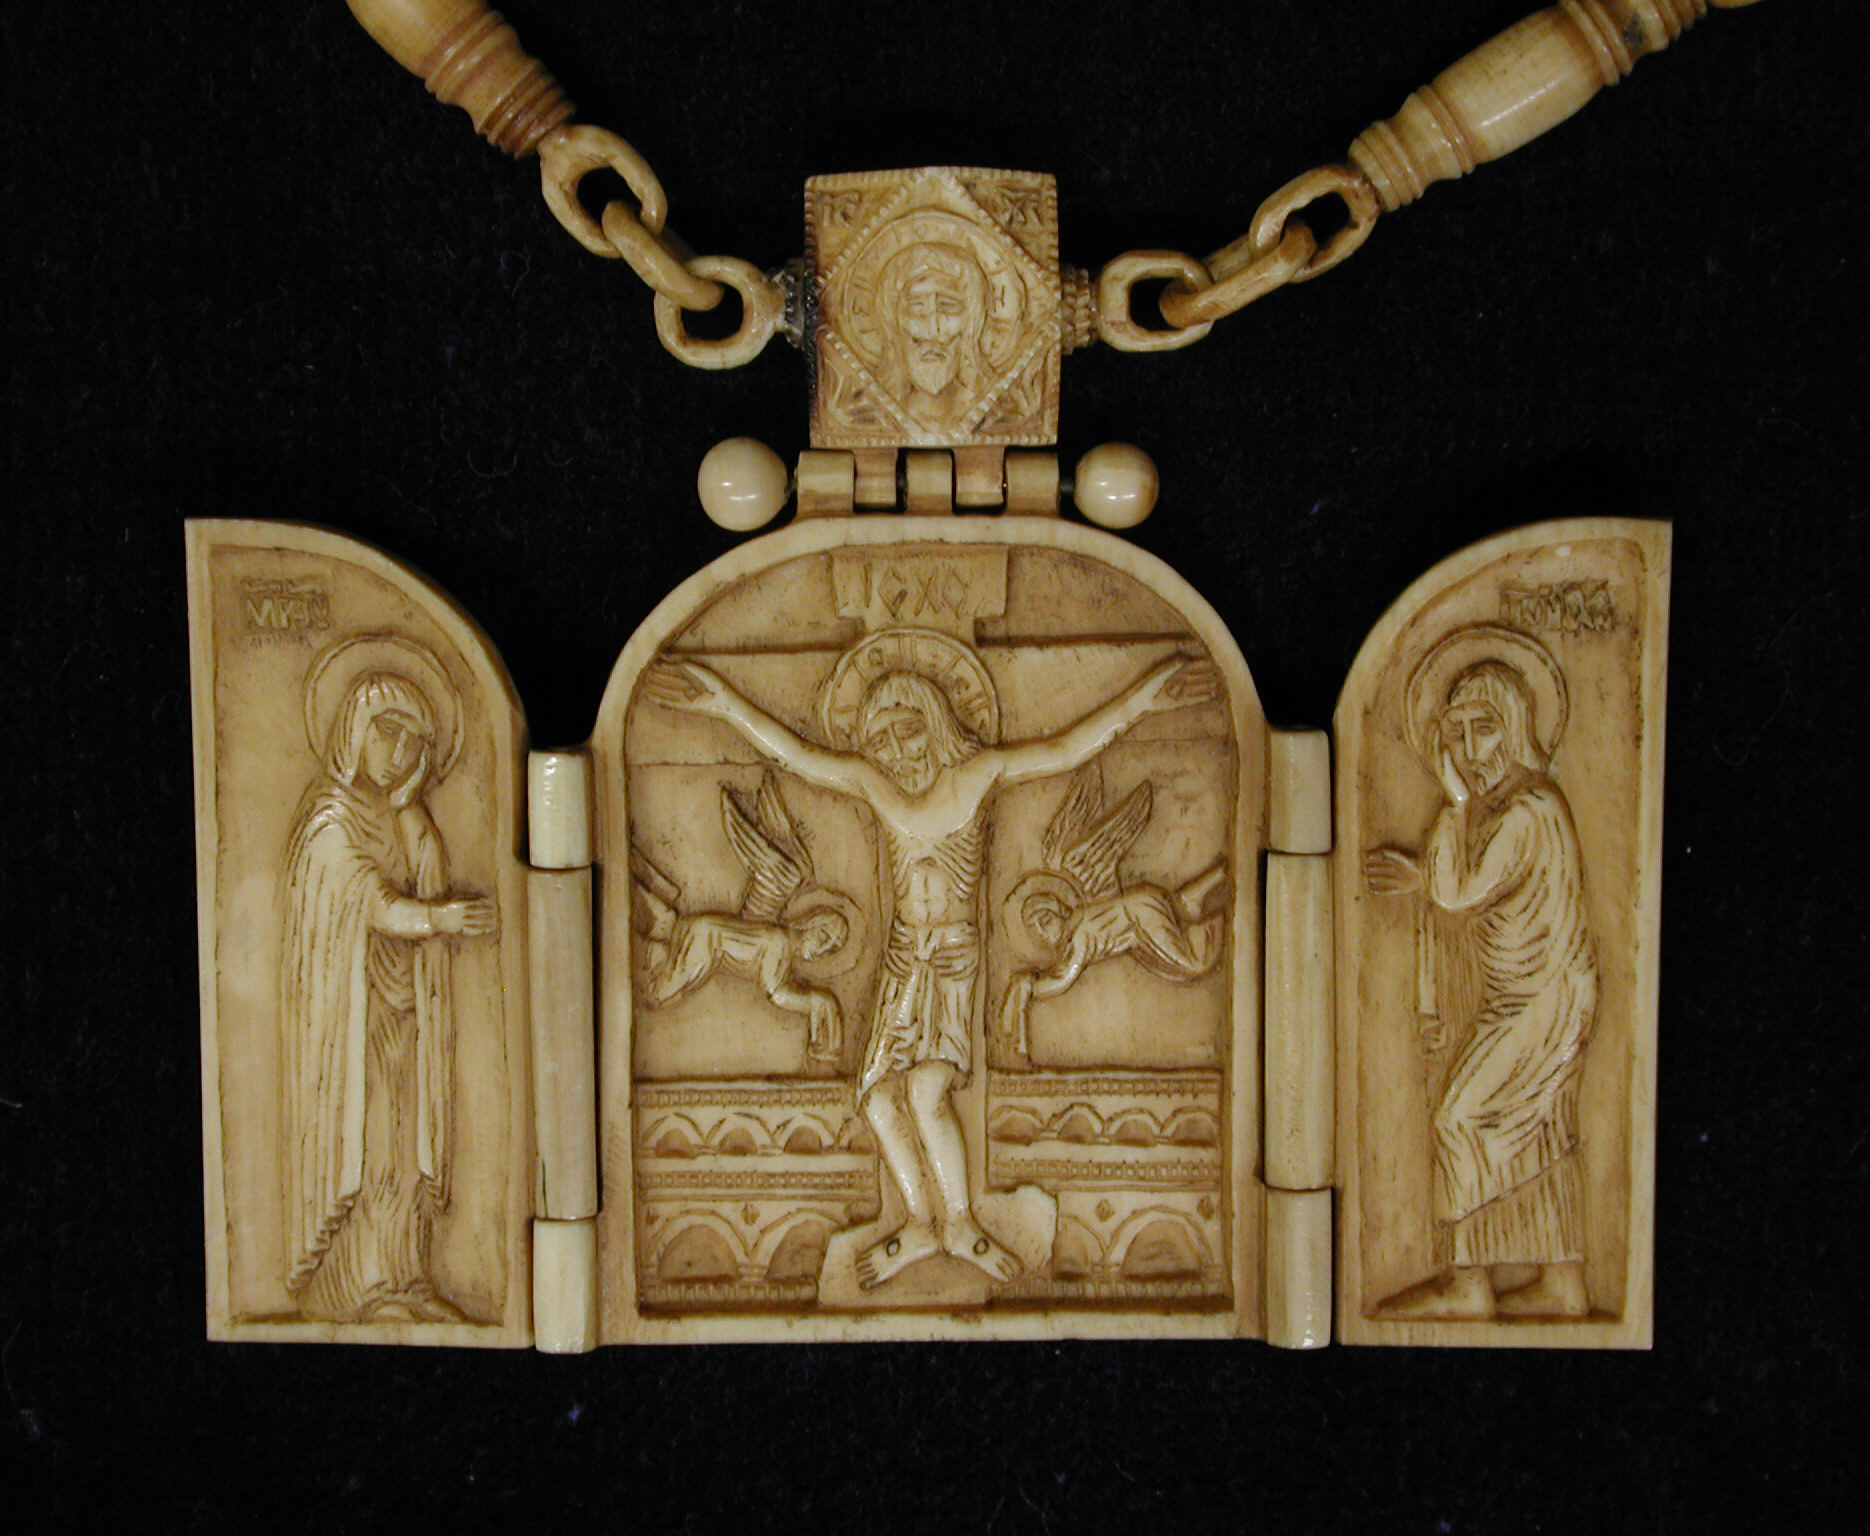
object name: triptych on chain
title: Triptych on a chain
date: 1701-1800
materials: ivory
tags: angels,christ,virgin mary,crucifixion